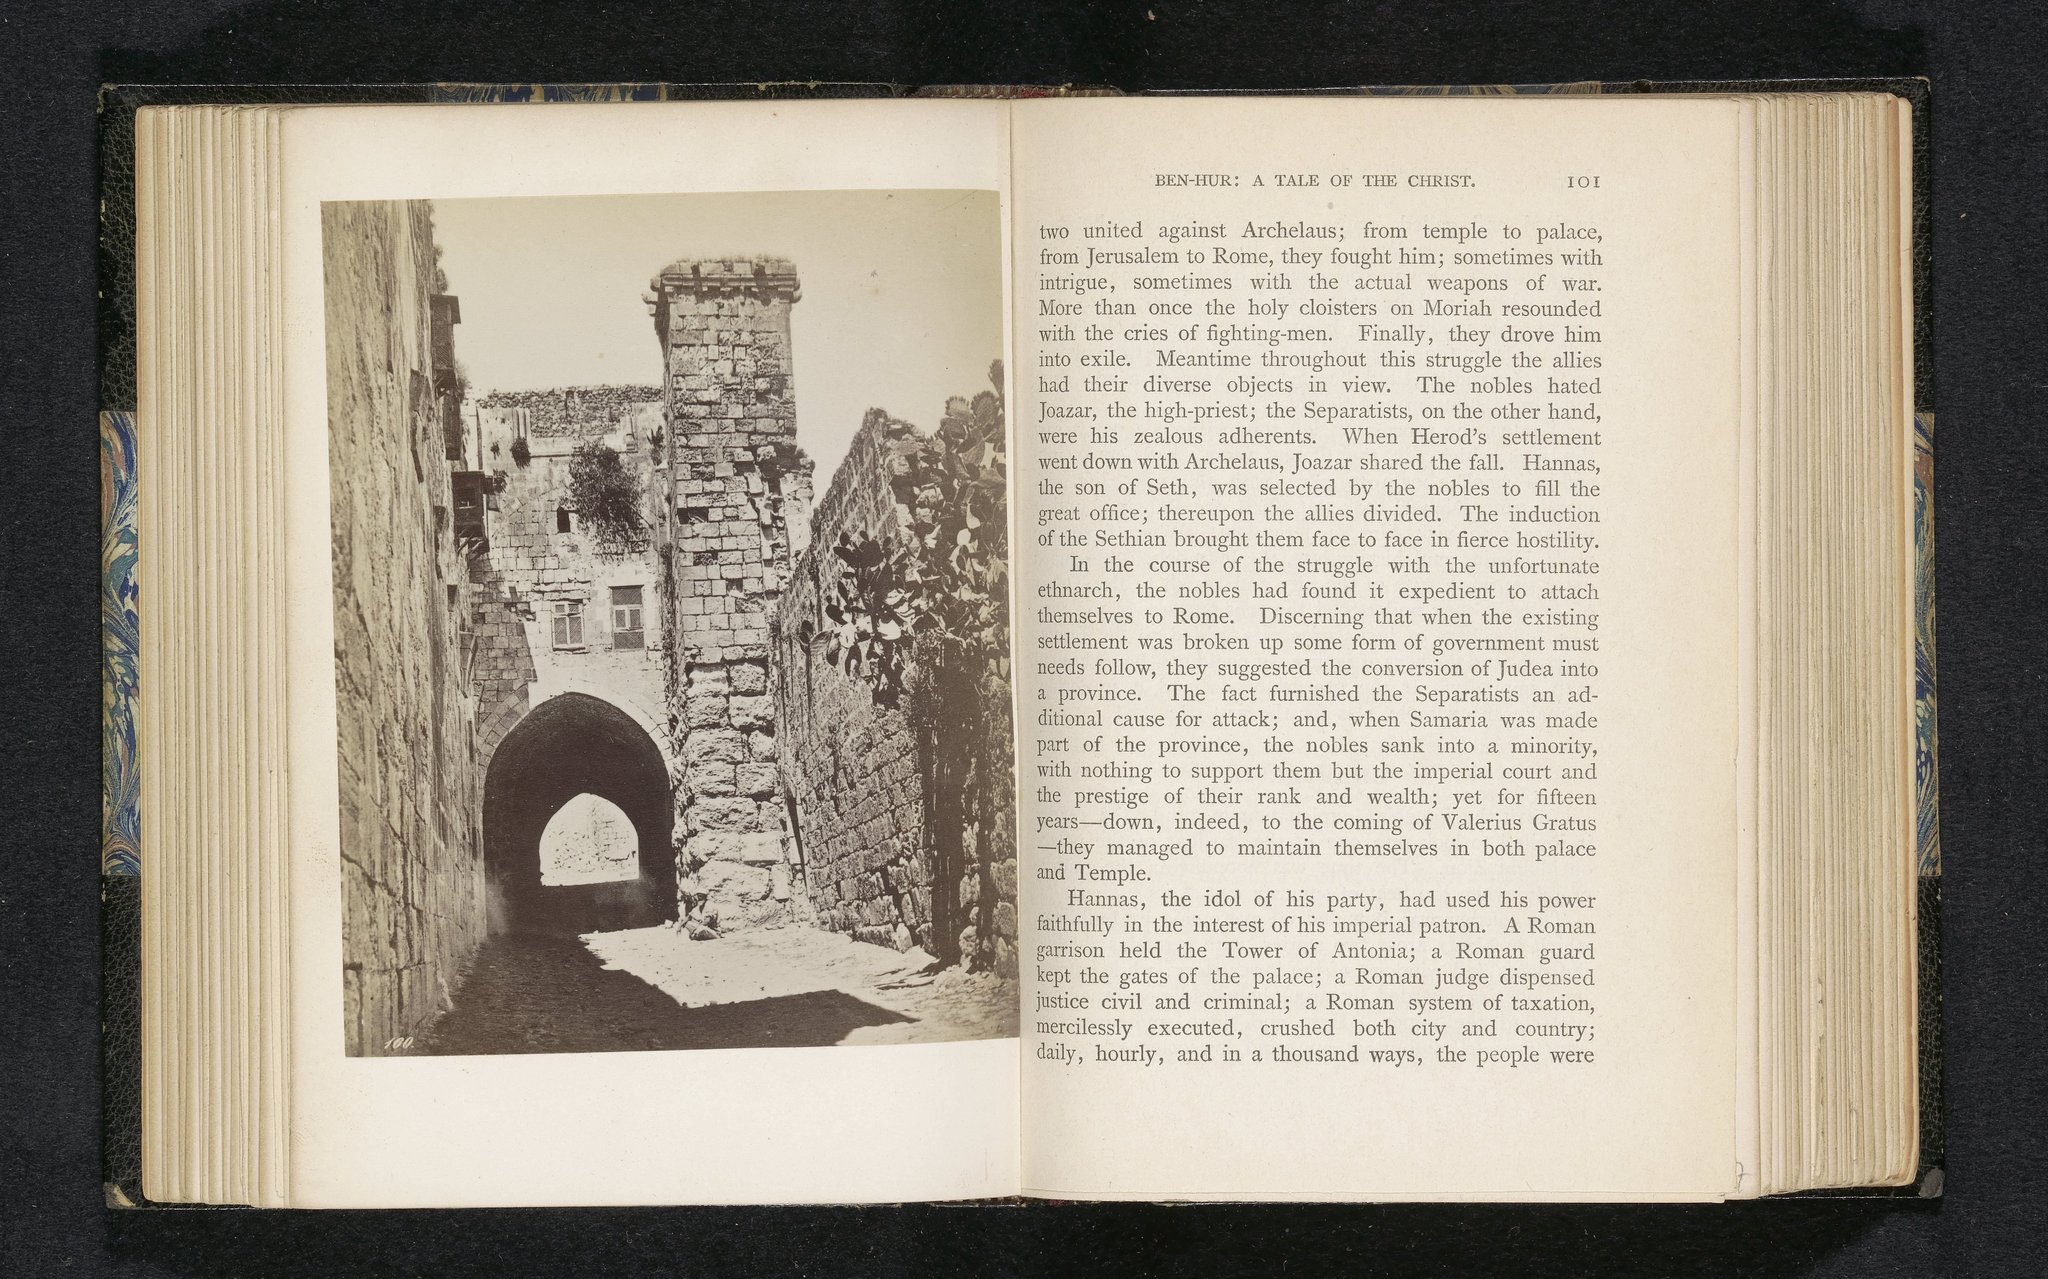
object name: photograph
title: Toren van de burcht Antonia te Jeruzalem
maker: Anonymous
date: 1883-1888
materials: photographic support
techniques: albumen print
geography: jerusalem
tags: towers ~ fortified city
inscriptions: number: ‘160’